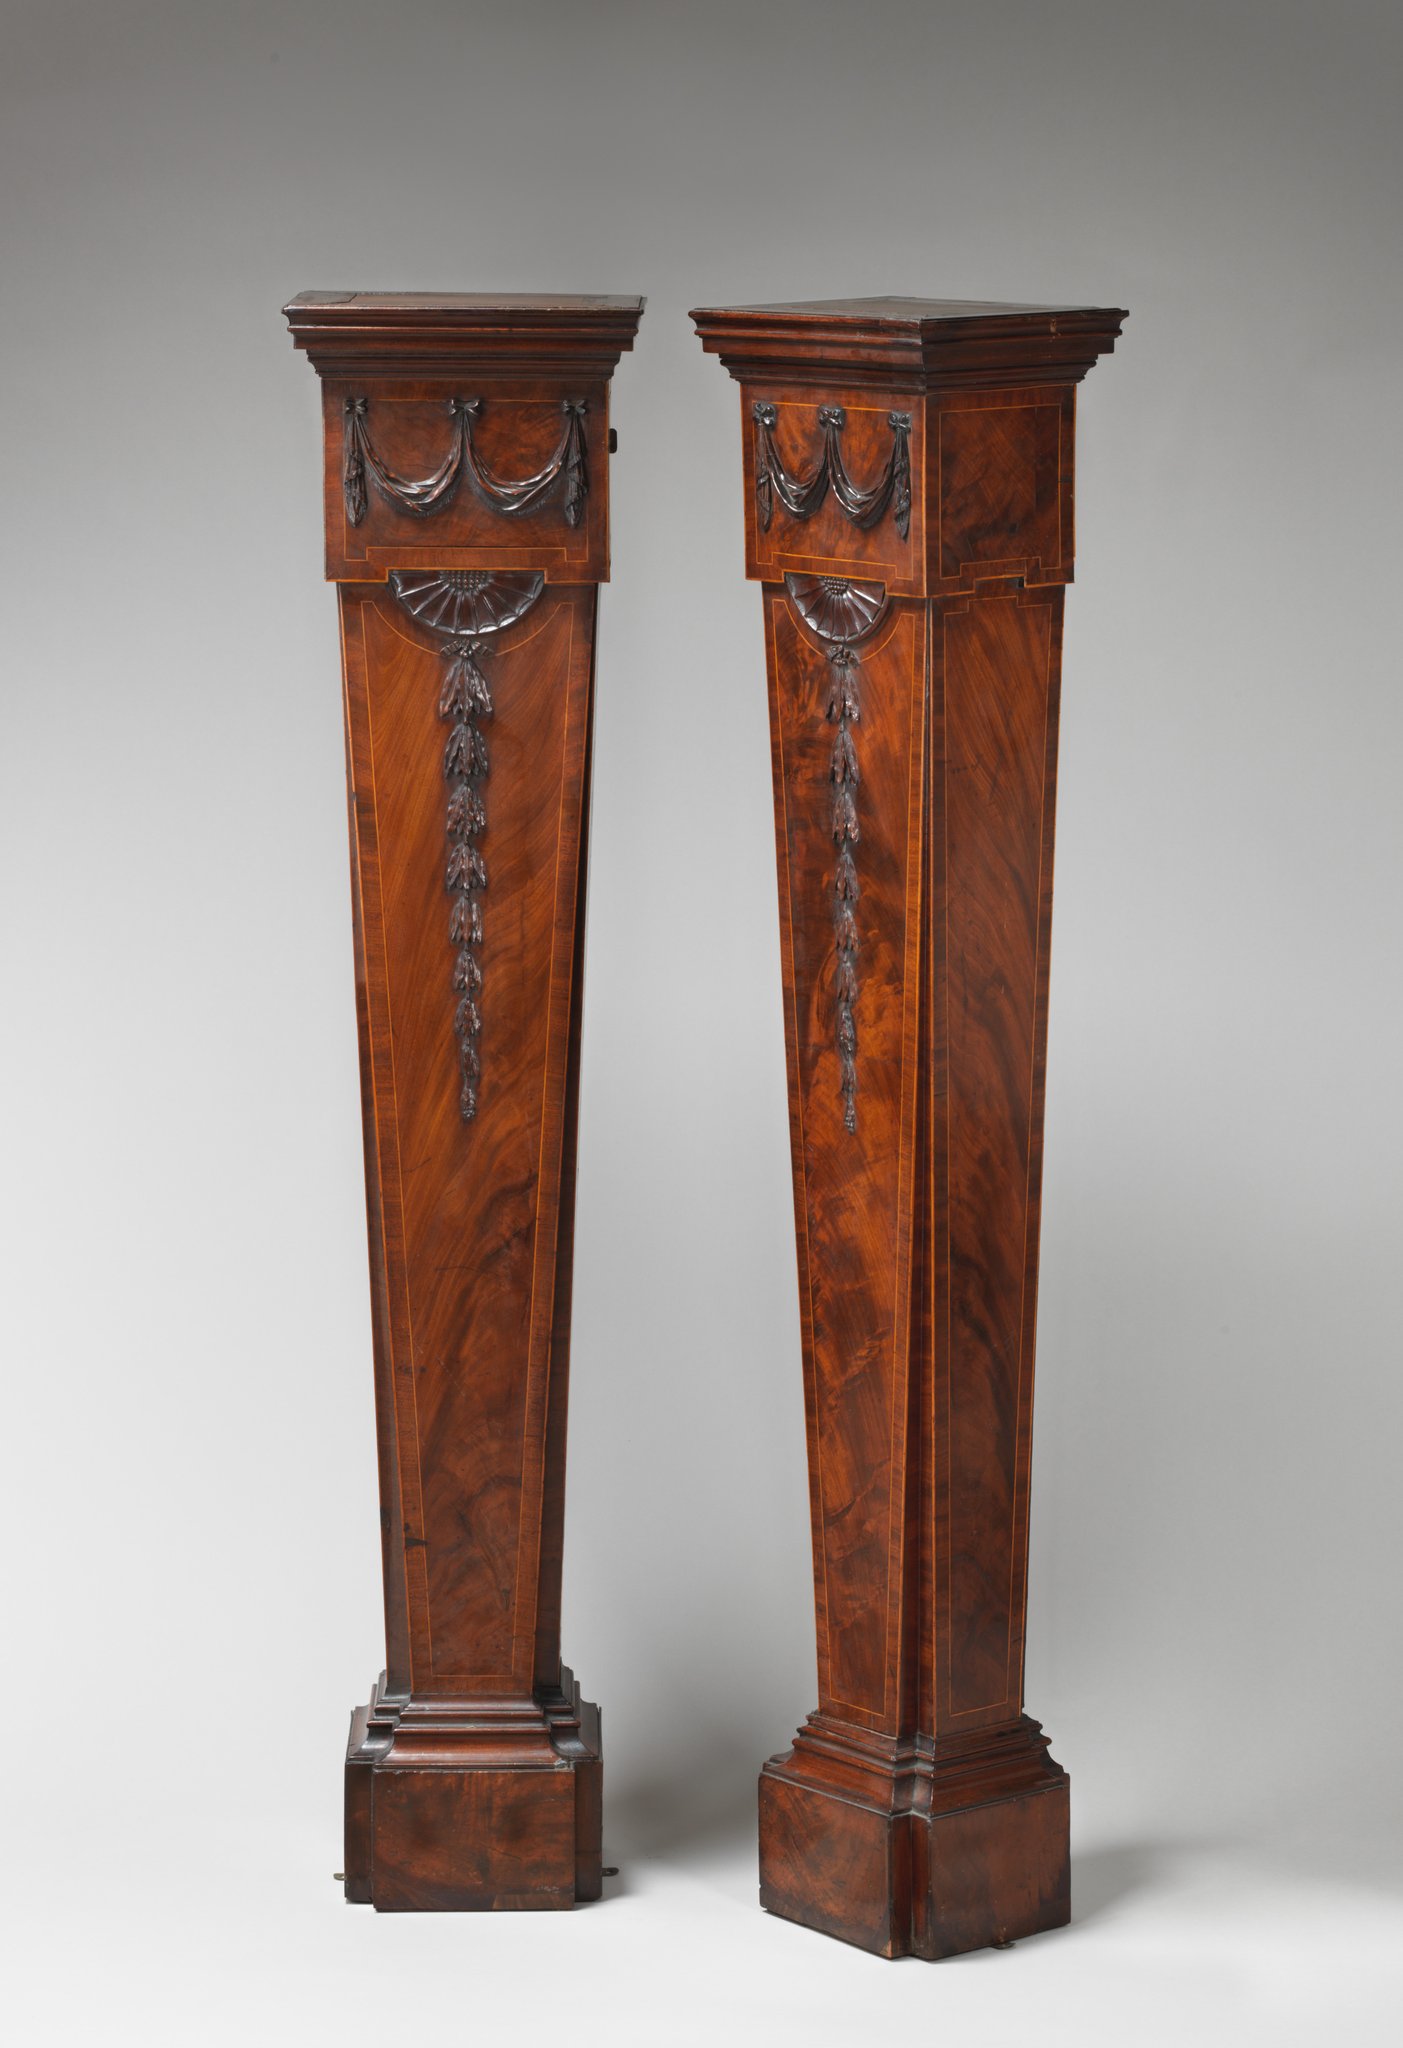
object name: pedestal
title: Pair of wall pedestals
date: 1775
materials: wood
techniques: inlay, veneering